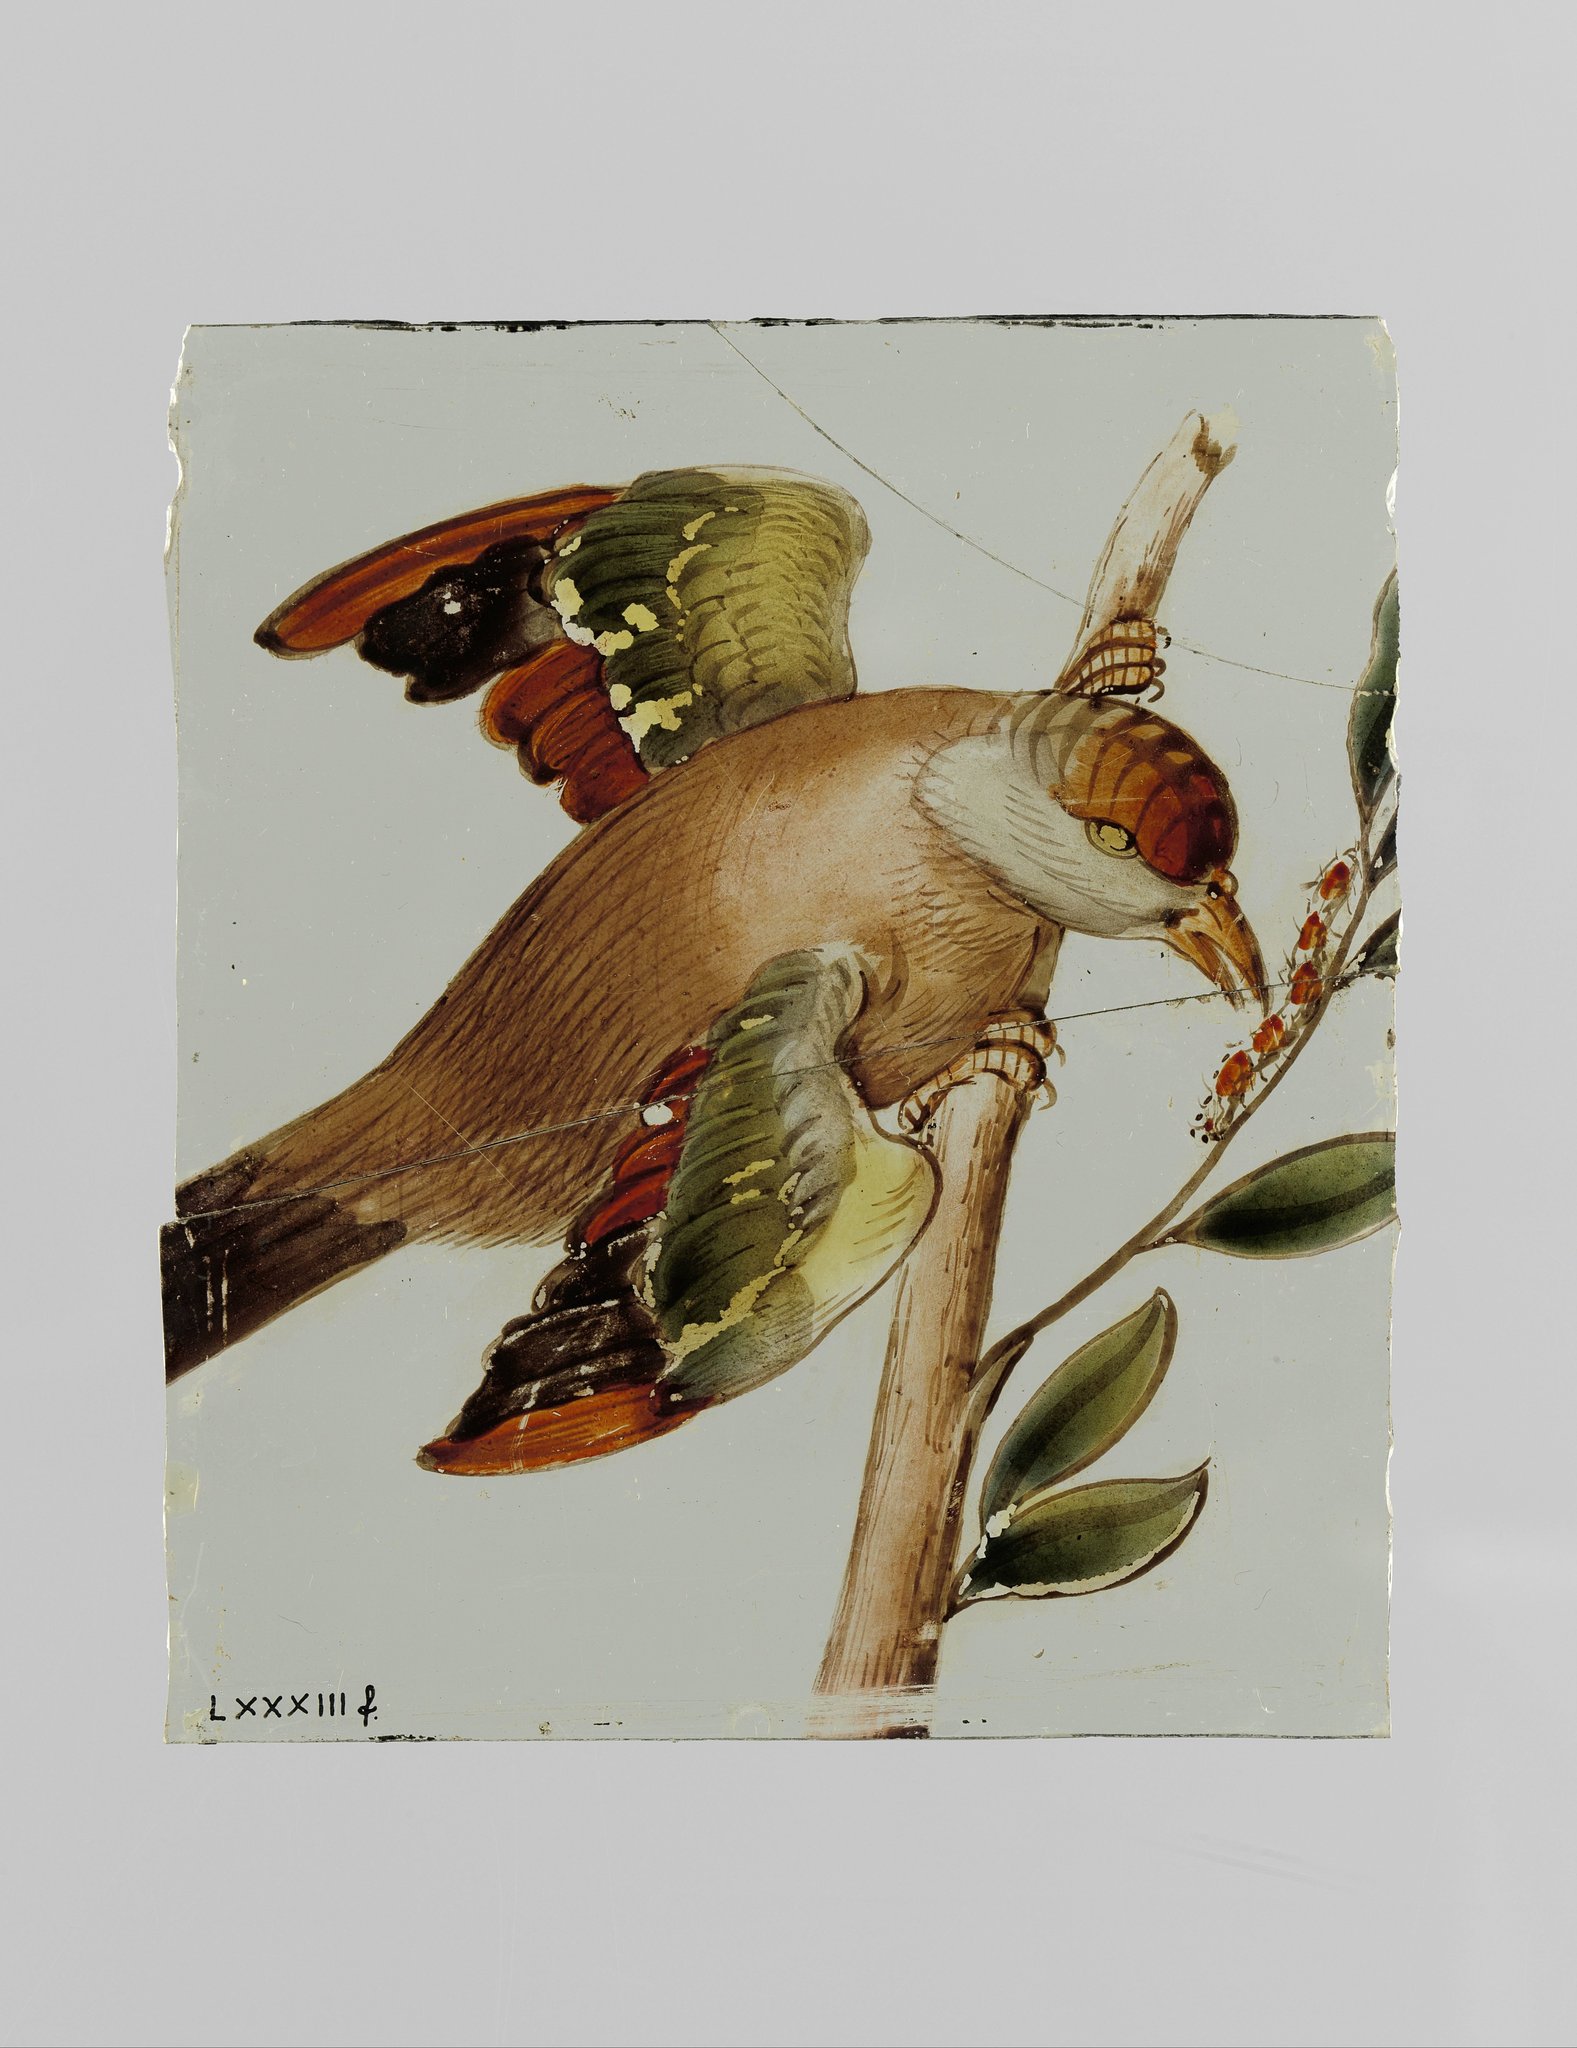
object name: light window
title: Ruit met een vogel die naar een rups pikt op een tak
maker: Anonymous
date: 1650-1675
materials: glass, lead, pigment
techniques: enamel painting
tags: birds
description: Een ruit met emailschildering van een vogel in rood, zilvergeel, blauw en grisaille die naar een rups pikt.